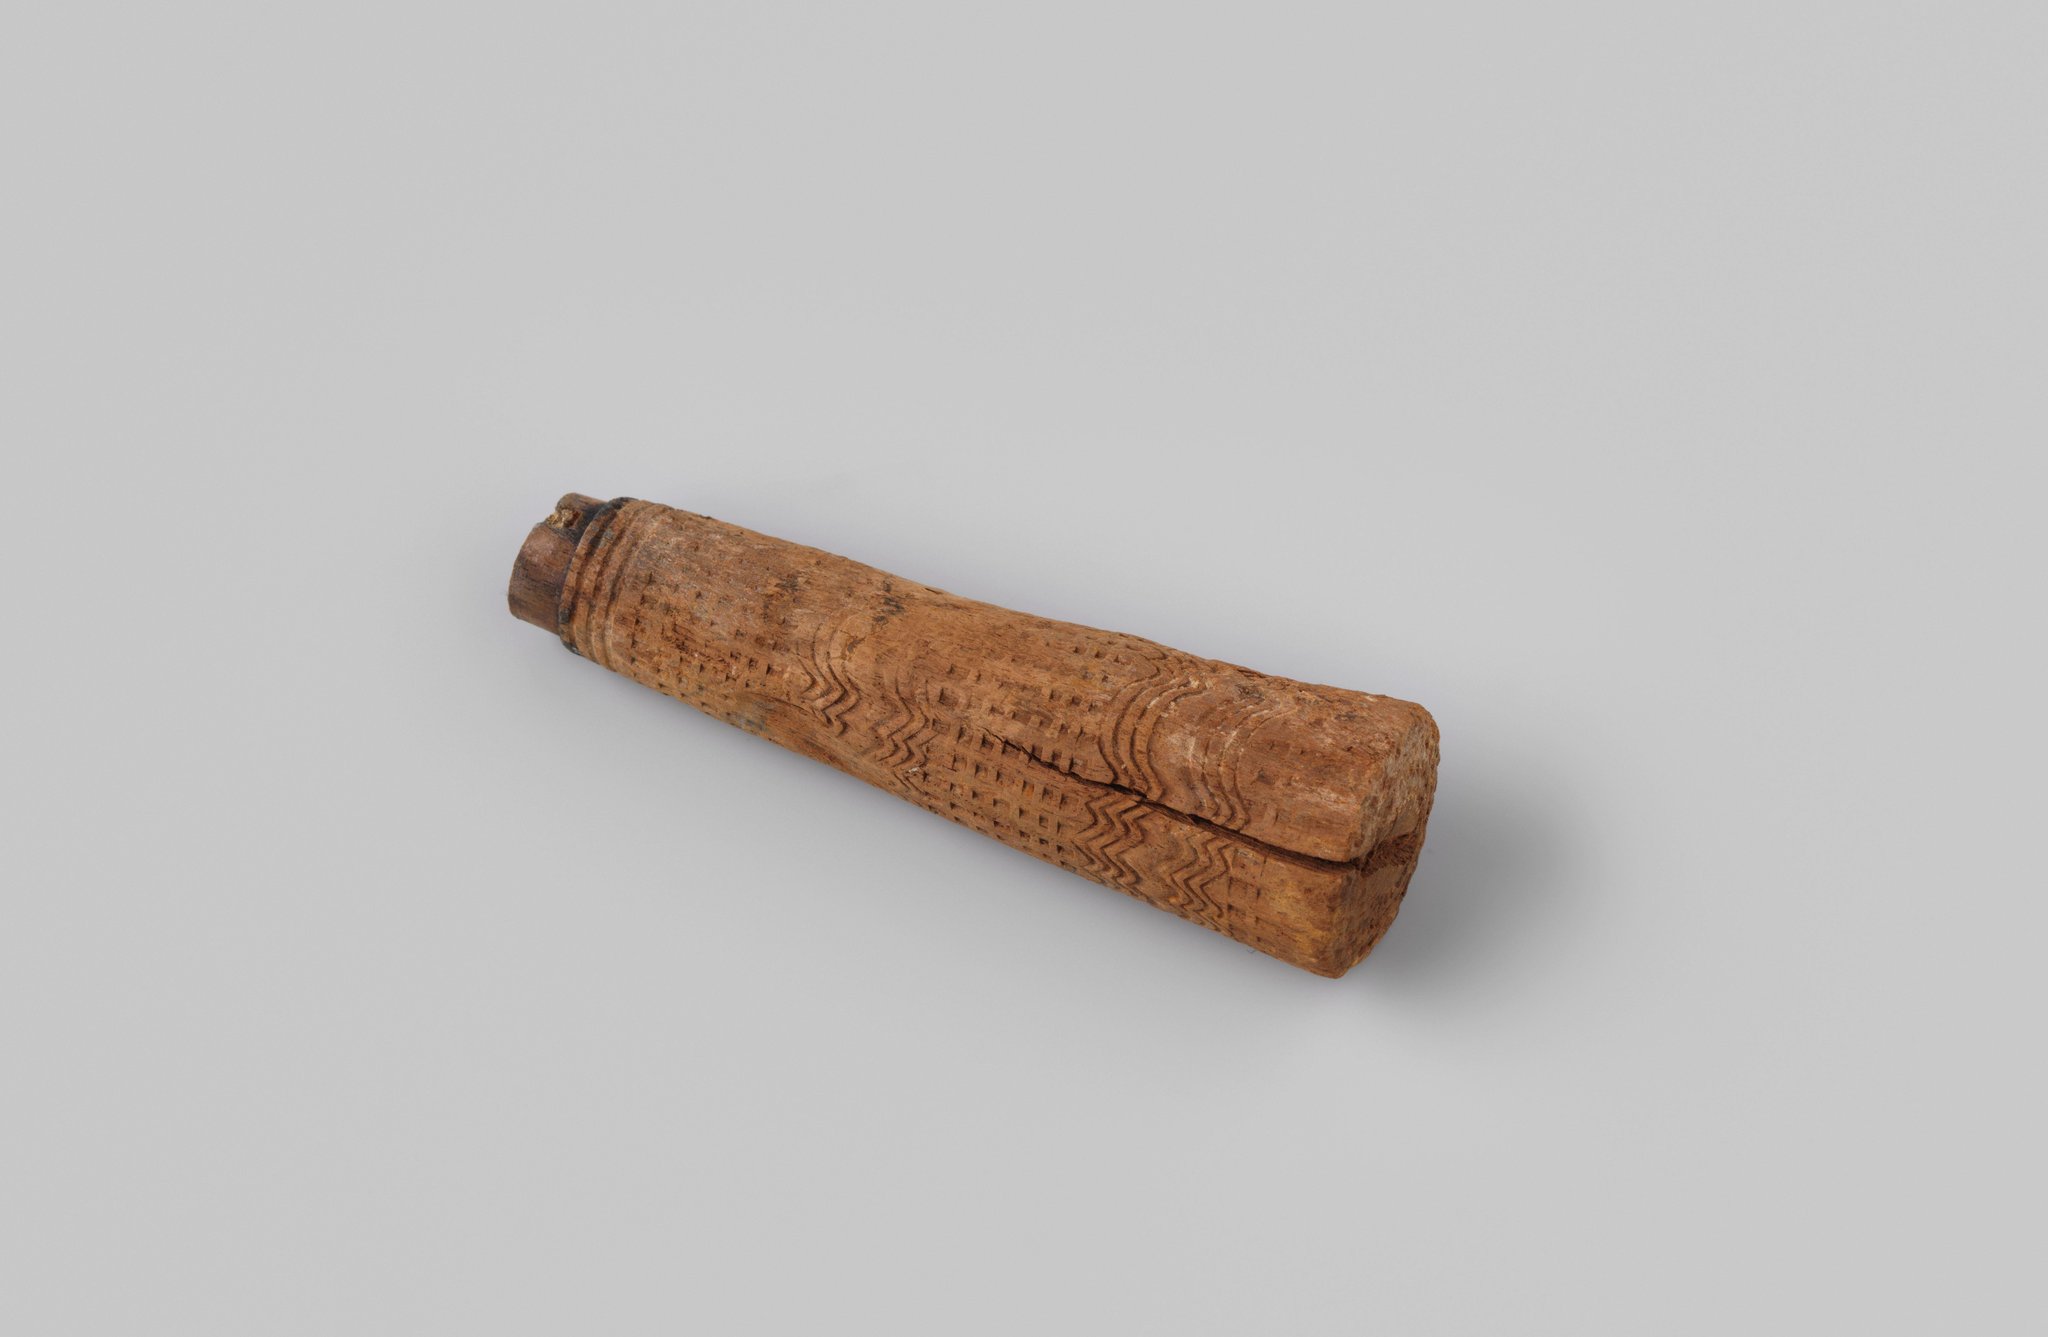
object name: knife handle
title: Messenheft uit het wrak van de Oost-Indiëvaarder Hollandia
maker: Anonymous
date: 1700-1743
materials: wood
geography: netherlands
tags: verenigde oostindische compagnie, hollandia (schip), annet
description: Knife, handle, cylindrical: tapering; id. NG 1979-403H, ferrules id. NG 1980-27H426.